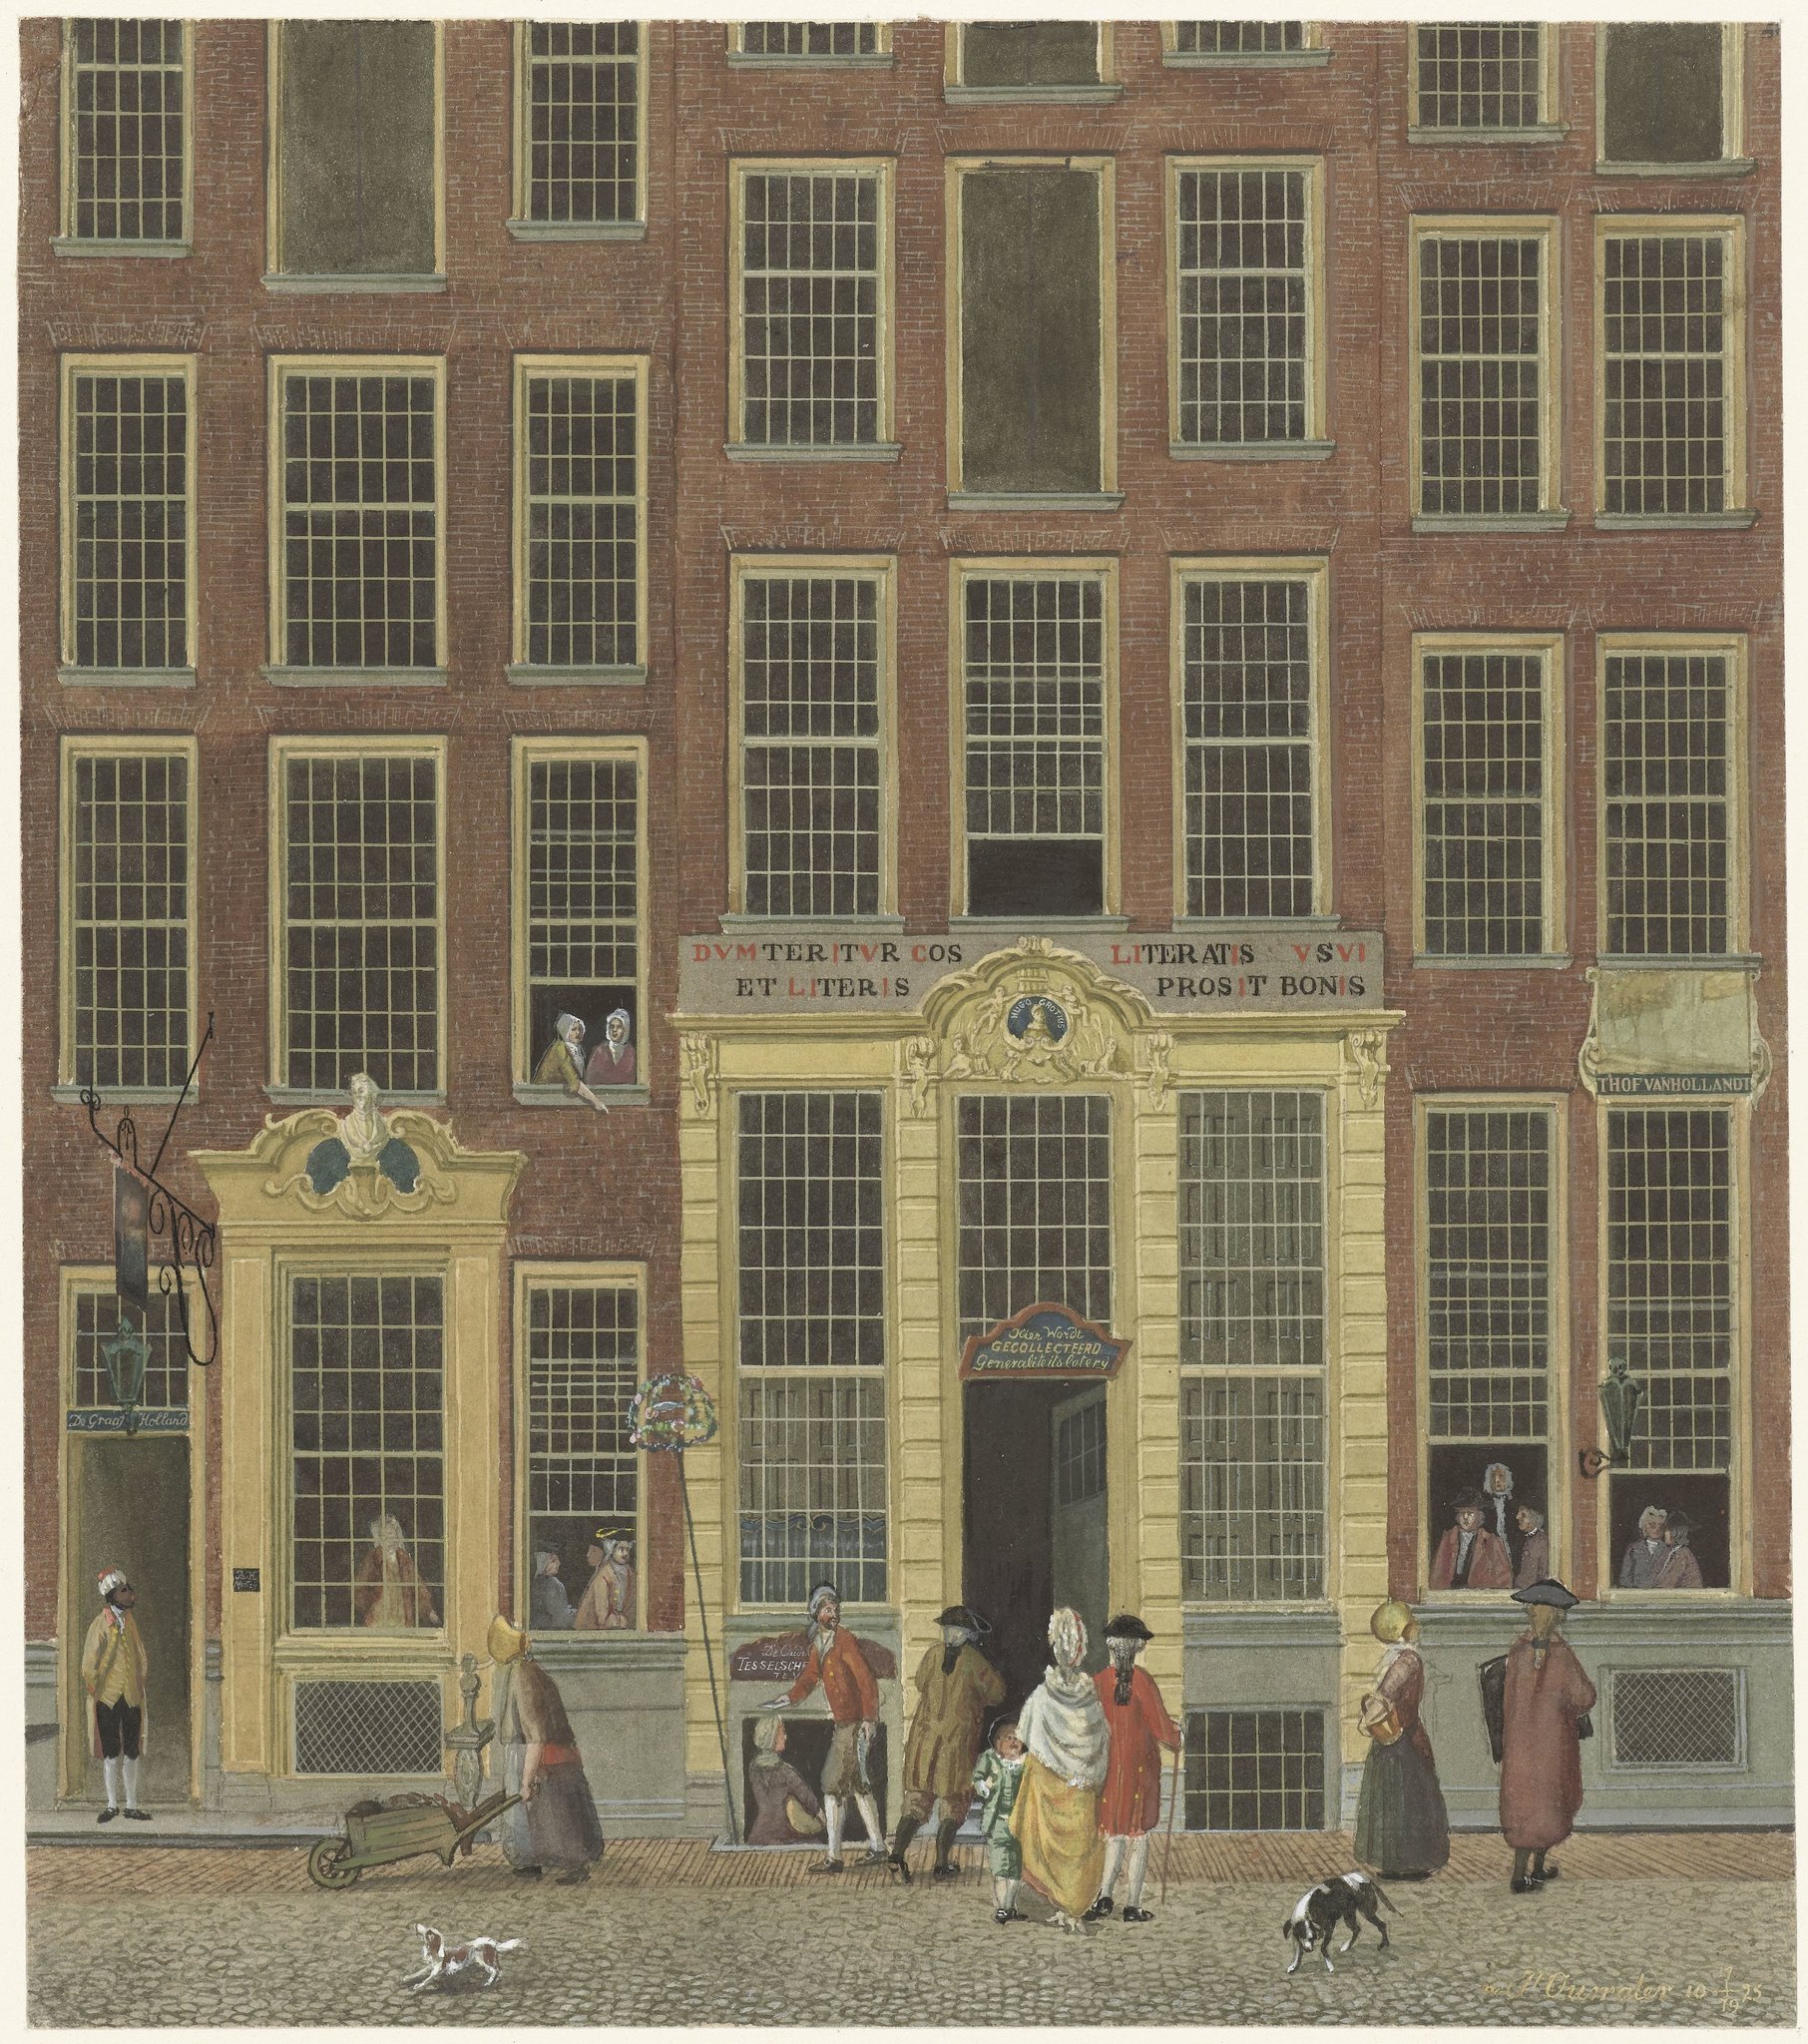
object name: drawing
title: De boekhandel en het loterijkantoor van Jan de Groot in de Kalverstraat te Amsterdam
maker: Anonymous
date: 1758-1843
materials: paint, paper, watercolor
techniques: brush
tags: historical persons, book-shop, bookseller